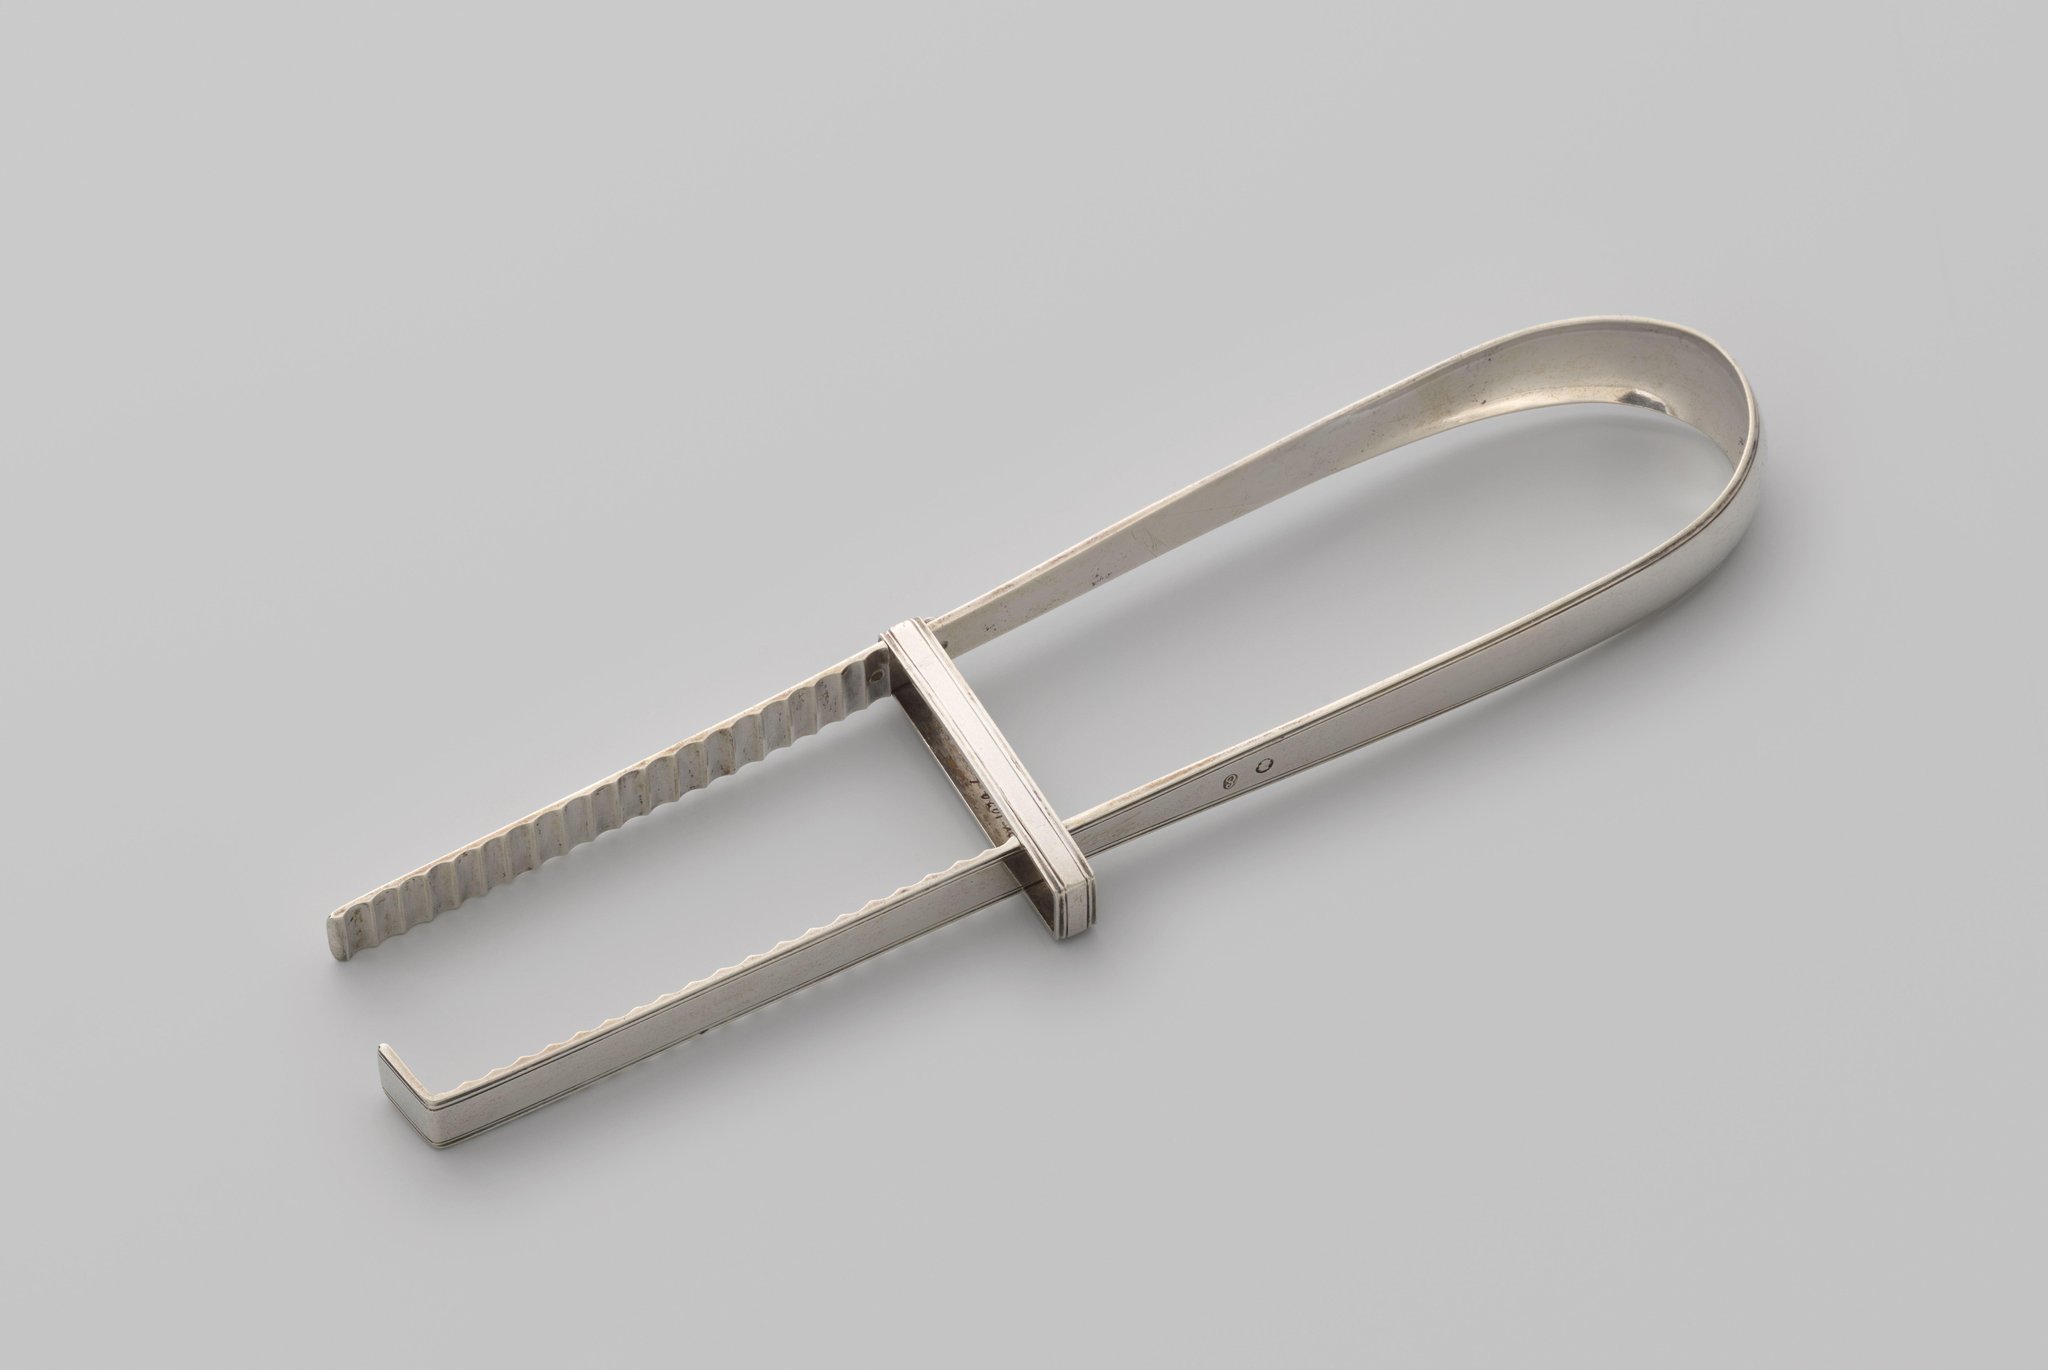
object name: asparagus tongs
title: Aspergetang met twee rechthoekige, aan de binnenzijde geribde grepen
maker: jan frederik everts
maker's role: silversmith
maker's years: 1756-1829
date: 1814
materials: silver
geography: amsterdam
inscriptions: maker's mark, alloy mark, date letter: ‘E’, assay office mark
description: De twee rechthoekige grepen, die aan de binnenzijde geribd zijn, zijn verbonden door een zich naar het midden toe verbredende steel. Eén van de grepen is aan het uiteinde rechthoekig omgebogen en wordt daar met een kort stukje voortgezet. Bij de aanzet van de andere greep is een rechthoekige haak met schroeven door korte uivormige uitsteeksels aan de tang bevestigd. Hierbinnen kan de eerste greep worden bewogen. Langs de randen van de buitenzijde van de tang en van de haak loopt een filetrand.